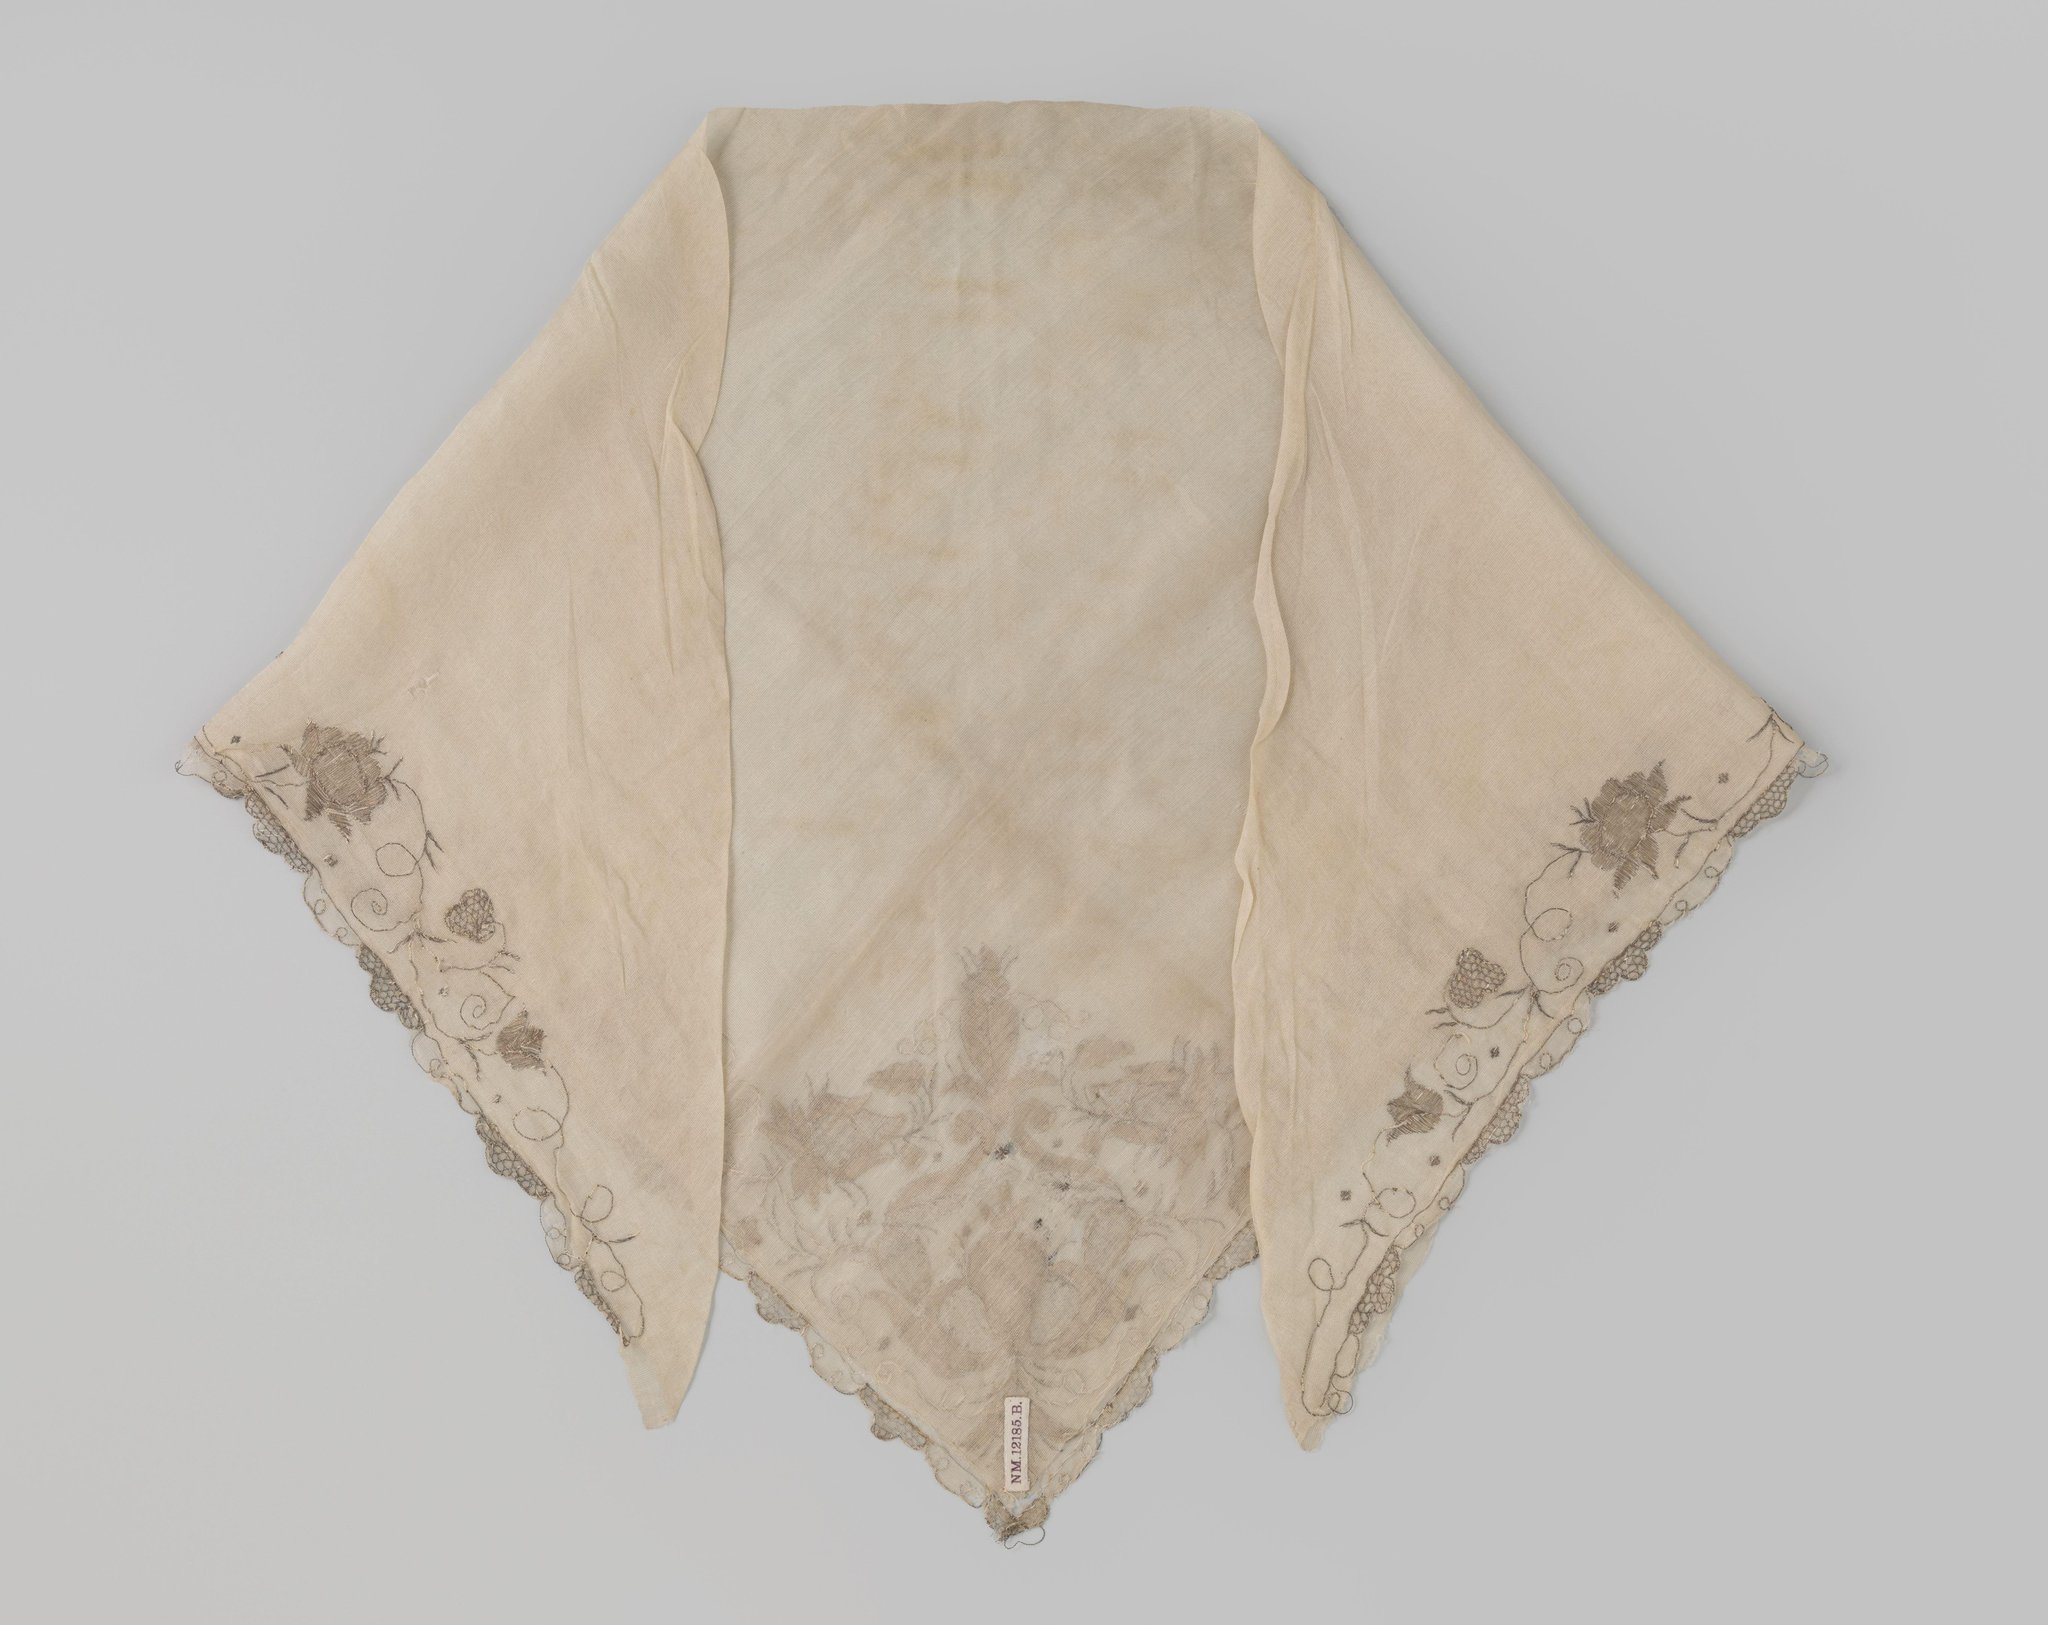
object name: fichu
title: Fichu van naturelkleurige zijde, driehoekig, langs twee zijden geschulpt en geborduurd met florale rand van zilverdraad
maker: Anonymous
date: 1700-1750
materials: silk, thread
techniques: embroidered, weave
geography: netherlands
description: Fichu van naturelkleurige zijde, driehoekig, langs twee zijden geschulpt en geborduurd met florale rand van zilverdraad. Model: oorspronkelijk vierkant, maar dubbelgeslagen en langs de twee schuine zijden met rijgsteken vastgezet. Schuin op de draad gewerkt. Versiering: in de punt een gestapeld symmetrisch ornament met bladeren en bloemen, waaruit aan weerszijden een meanderende slinger met bloemen. Langs en in de schulpen krullen en servetwerk. Voor de bloemen zijn verschillende steken gebruikt zoals de ingrijpsteek, steelsteek en naaldkantsteken.